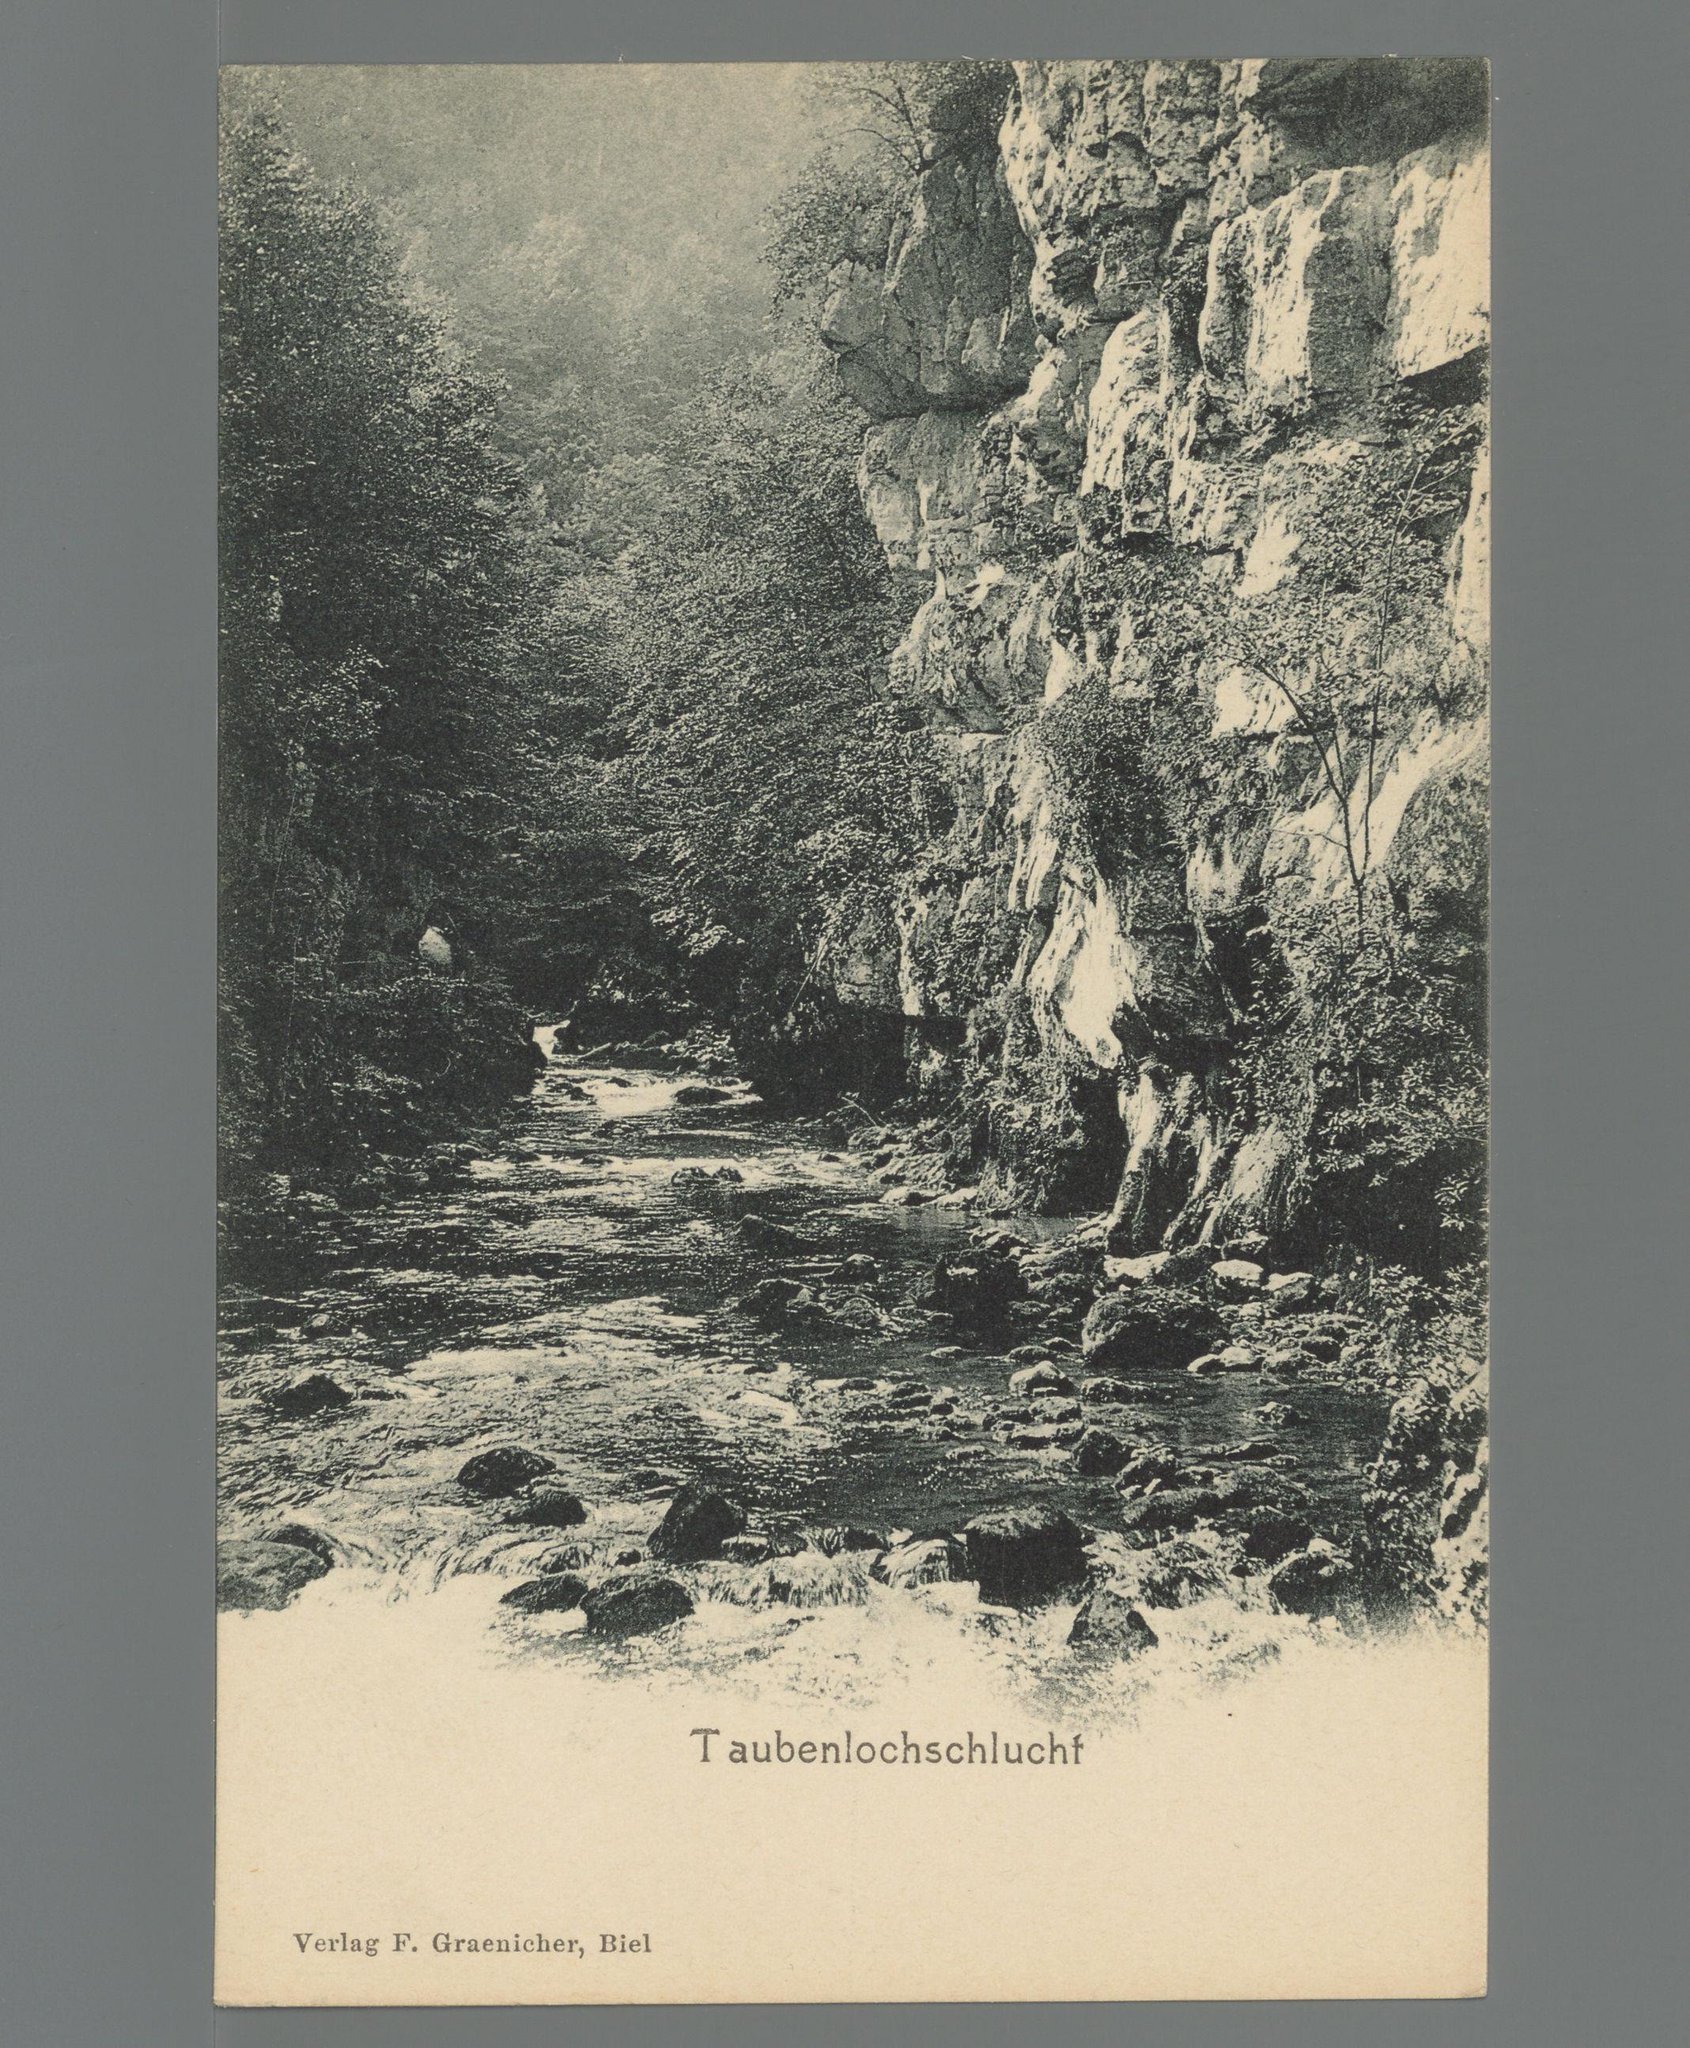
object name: ansichtkaart, prentbriefkaart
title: Taubenlochschlucht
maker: Anonymous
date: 1890-1905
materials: cardboard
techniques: photograph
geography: biel/bienne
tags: ravine, chasm, abyss, canyon